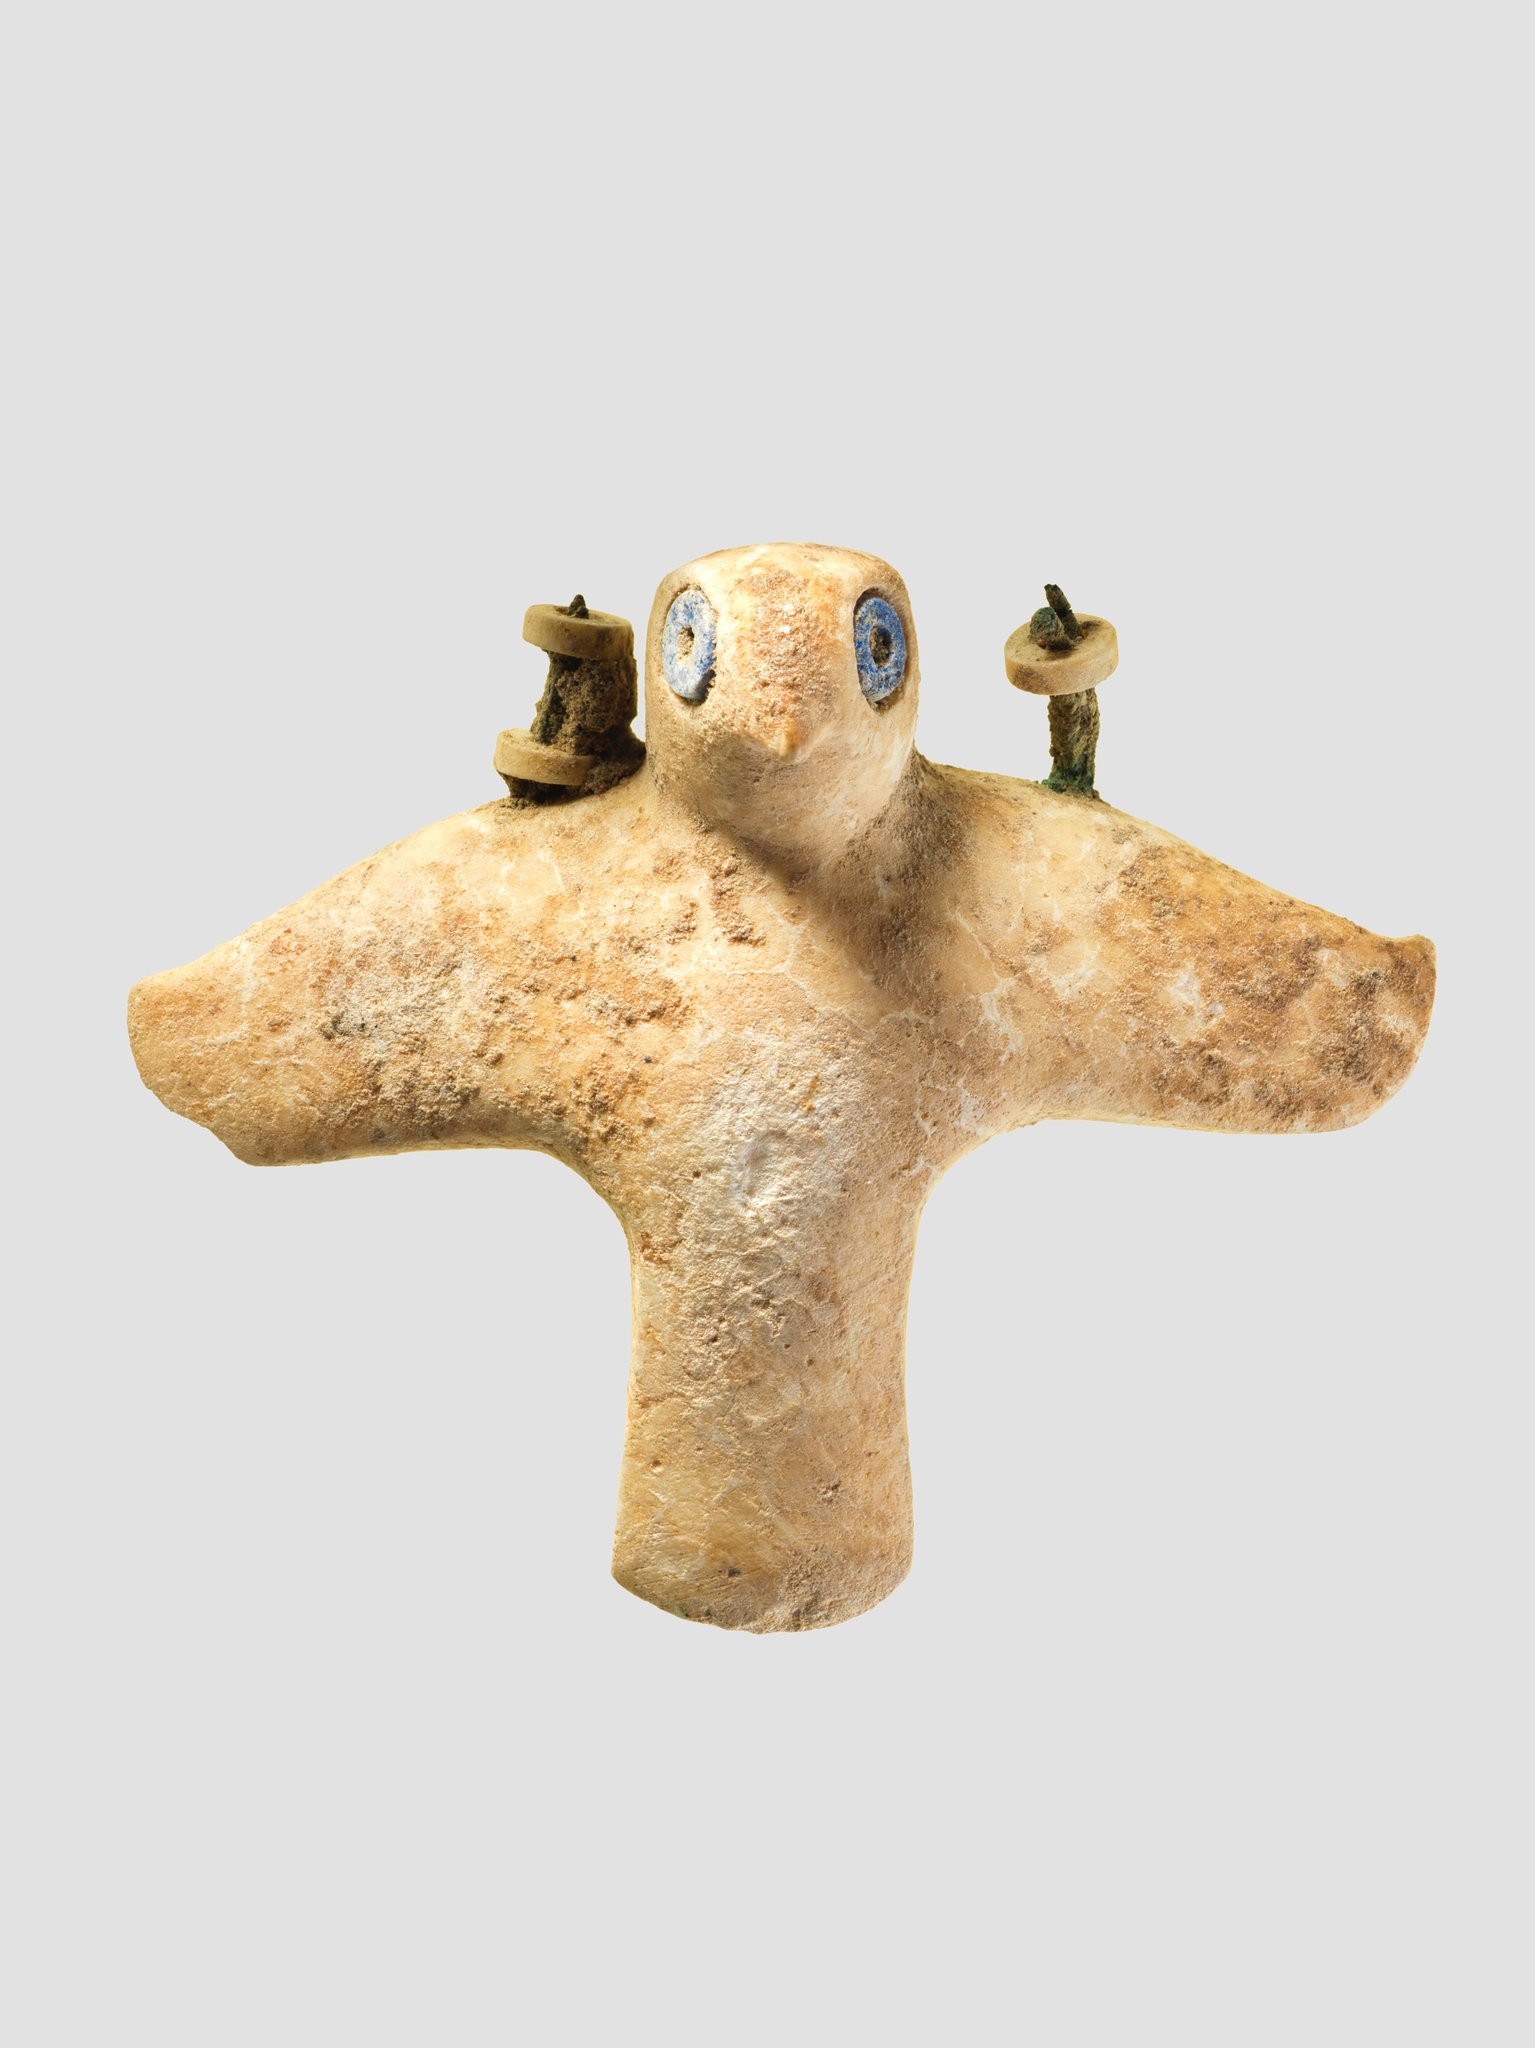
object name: sculpture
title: Bird of prey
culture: bactria-margiana archaeological complex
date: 2333-1668 BCE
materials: copper alloy, lapis lazuli, marble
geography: bactria-margiana or eastern iran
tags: birds